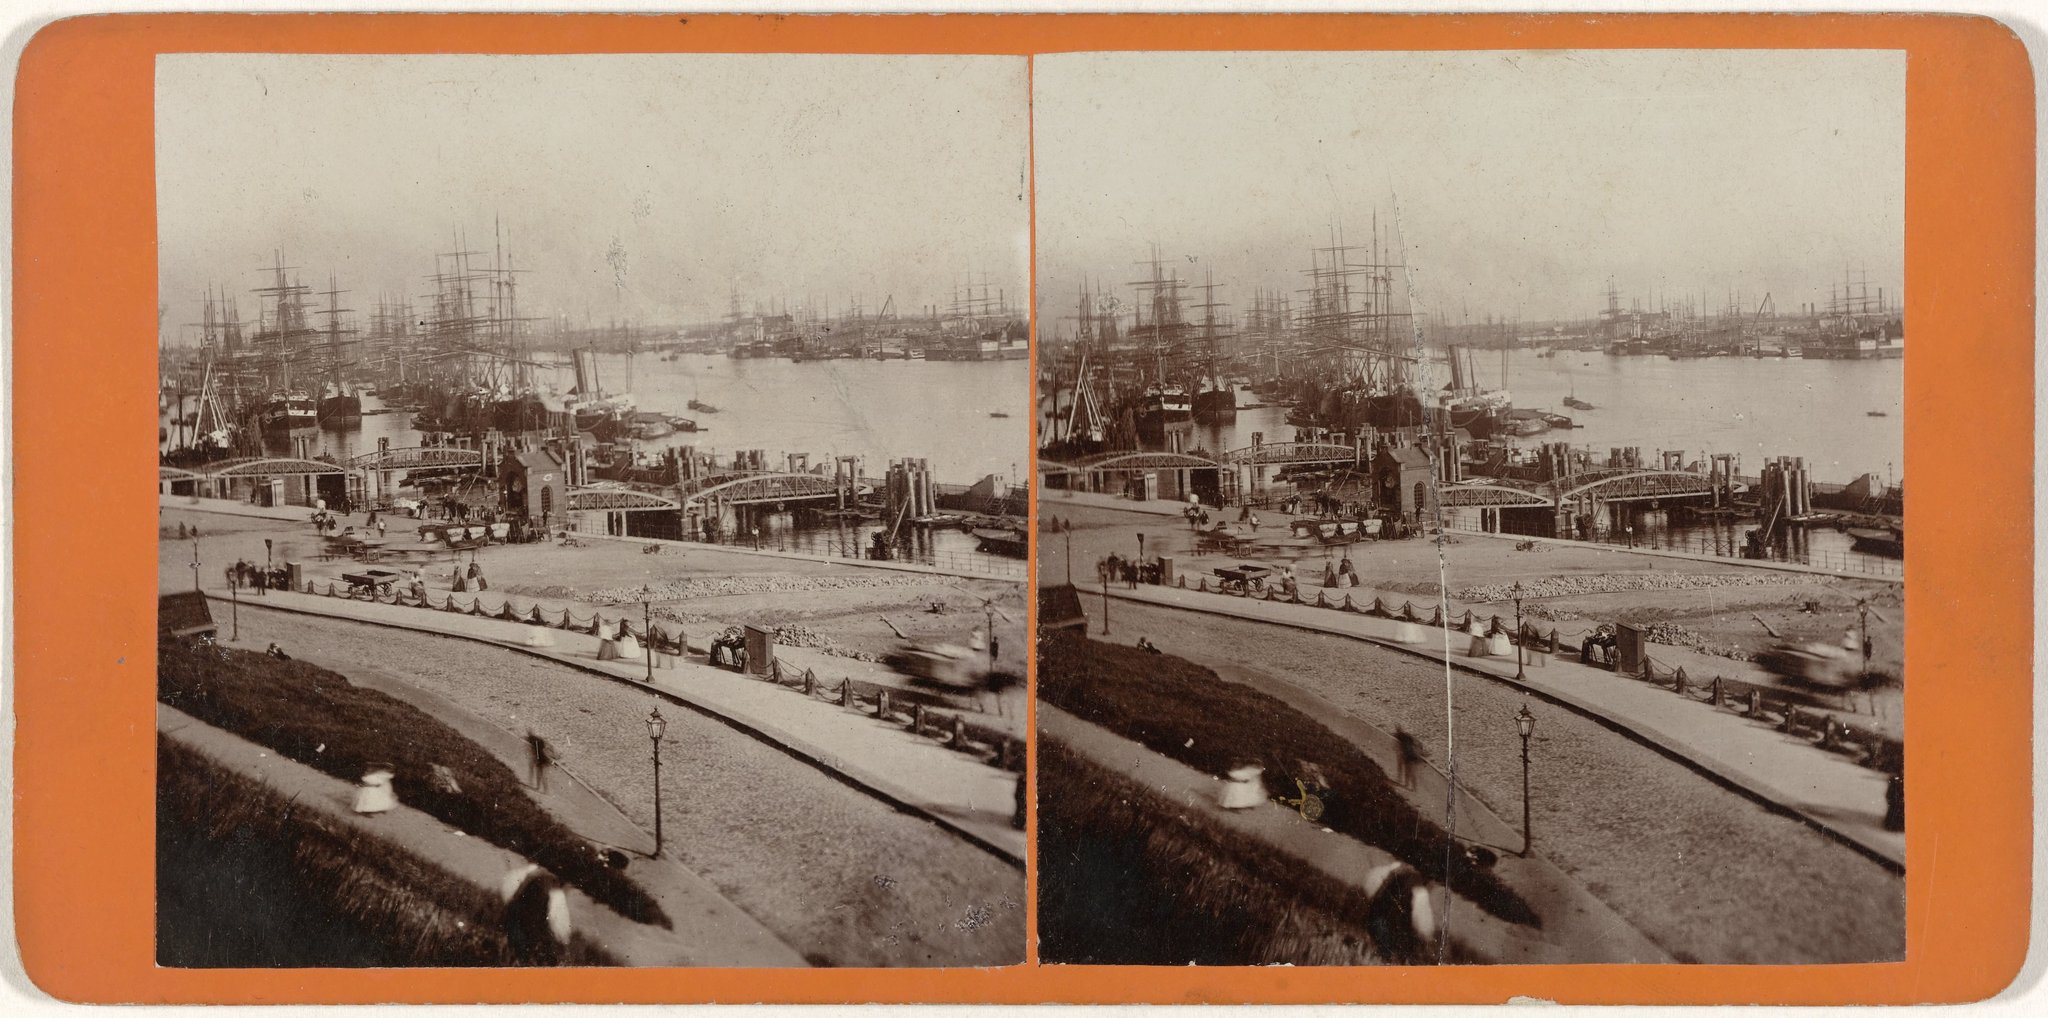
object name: stereograph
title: Haven van Hamburg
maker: Anonymous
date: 1873-1890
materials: cardboard, photographic support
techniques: collodion silver print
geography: hamburg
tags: harbour, ships (in general) - cc - more than one ship